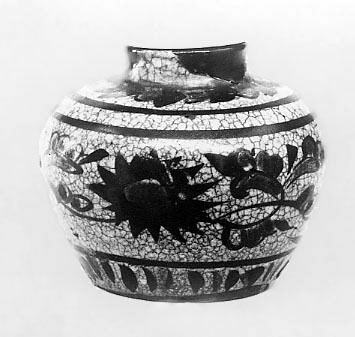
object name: tea jar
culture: japanese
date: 1701-1800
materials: clay, enamel, glaze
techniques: polychrome